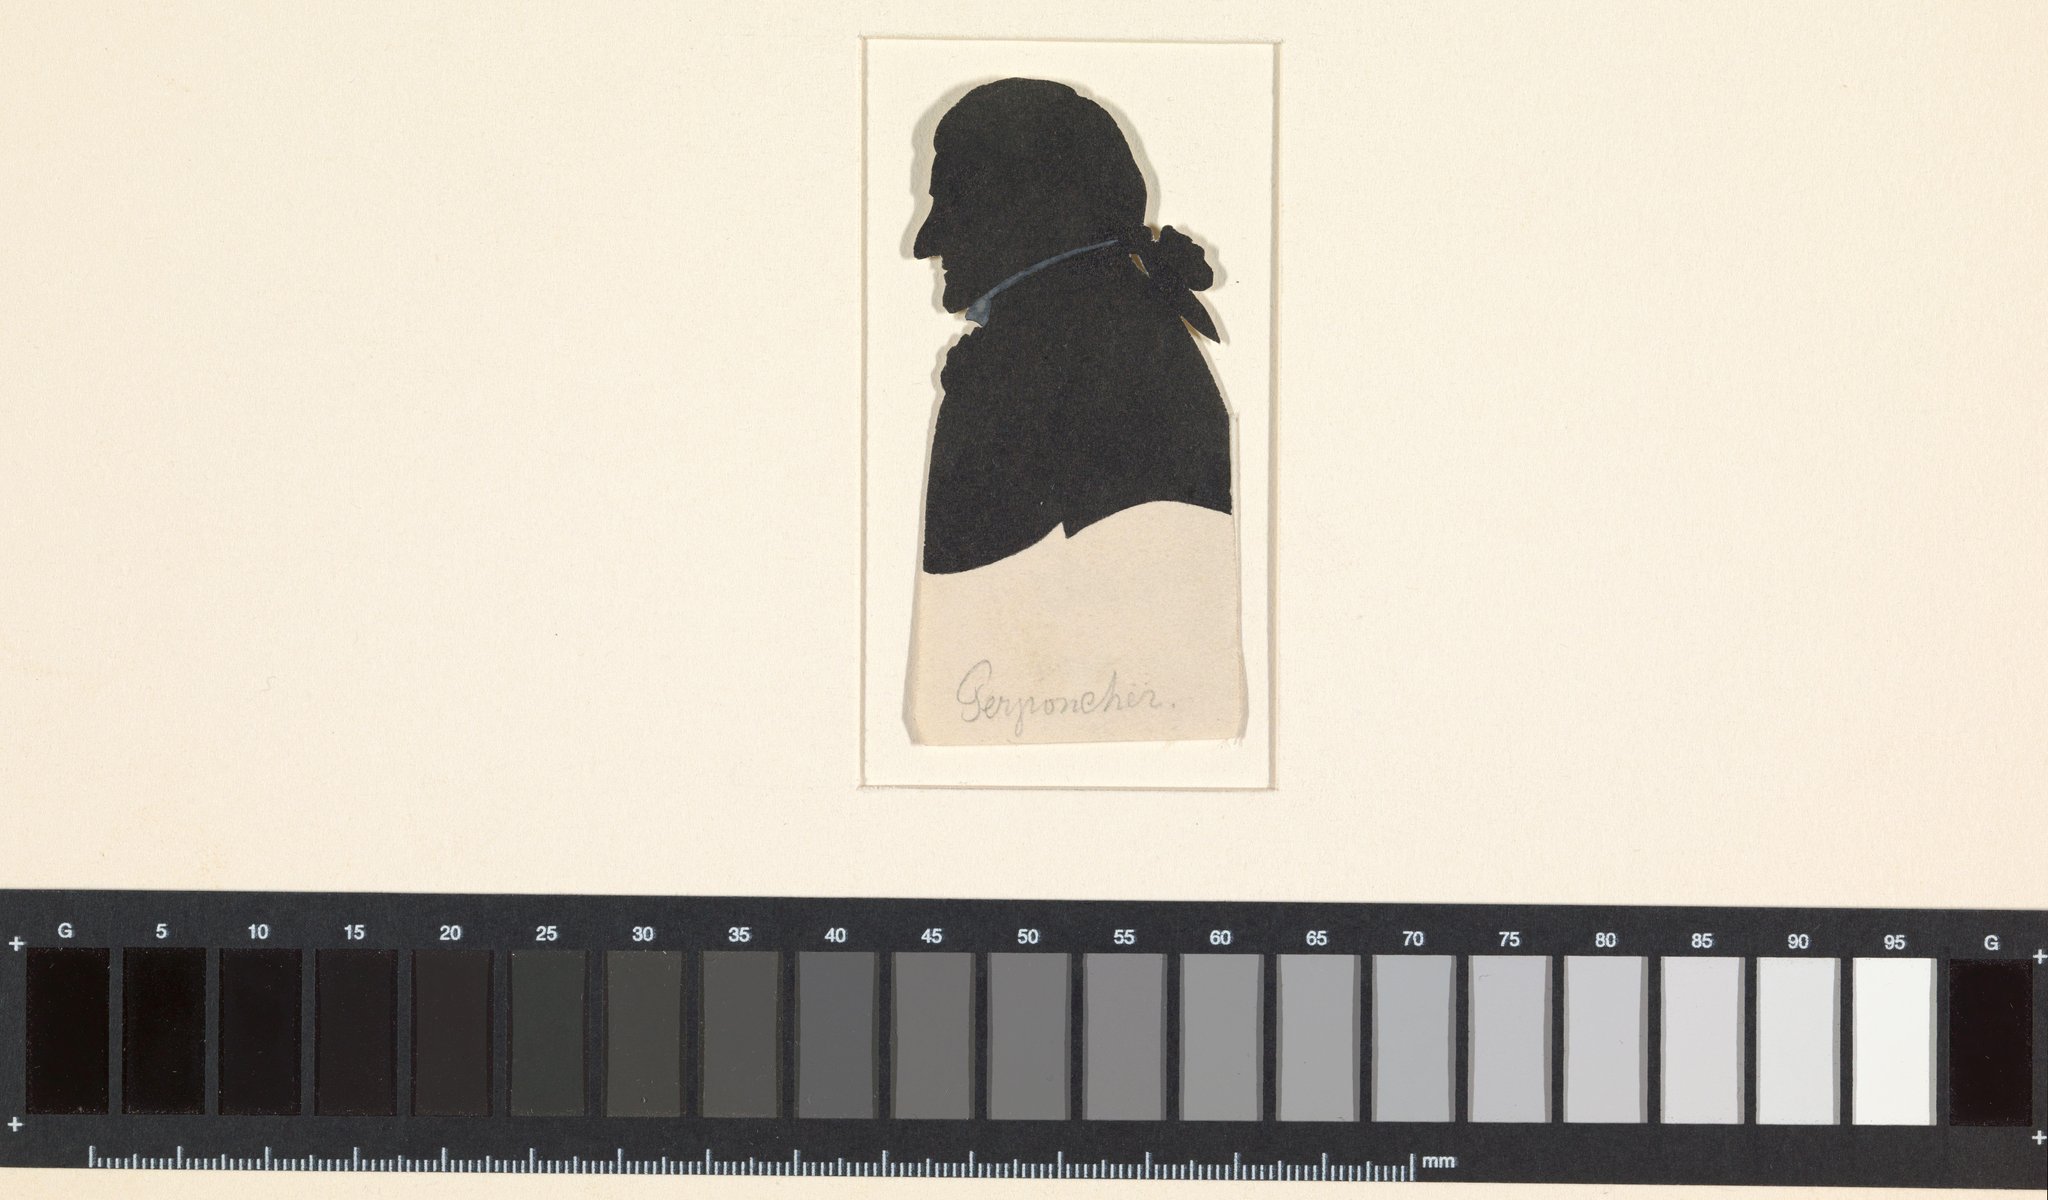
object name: drawing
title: Silhouet van Willem Emmery de Perponcher-Sedlwitzky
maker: casparis haanen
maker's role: draughtsman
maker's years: 1778-1849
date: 1788-1849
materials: paper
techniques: brush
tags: historical persons, male sex; man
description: Silhouet van Willem Emmery de Perponcher-Sedlwitzky (1740-1819).